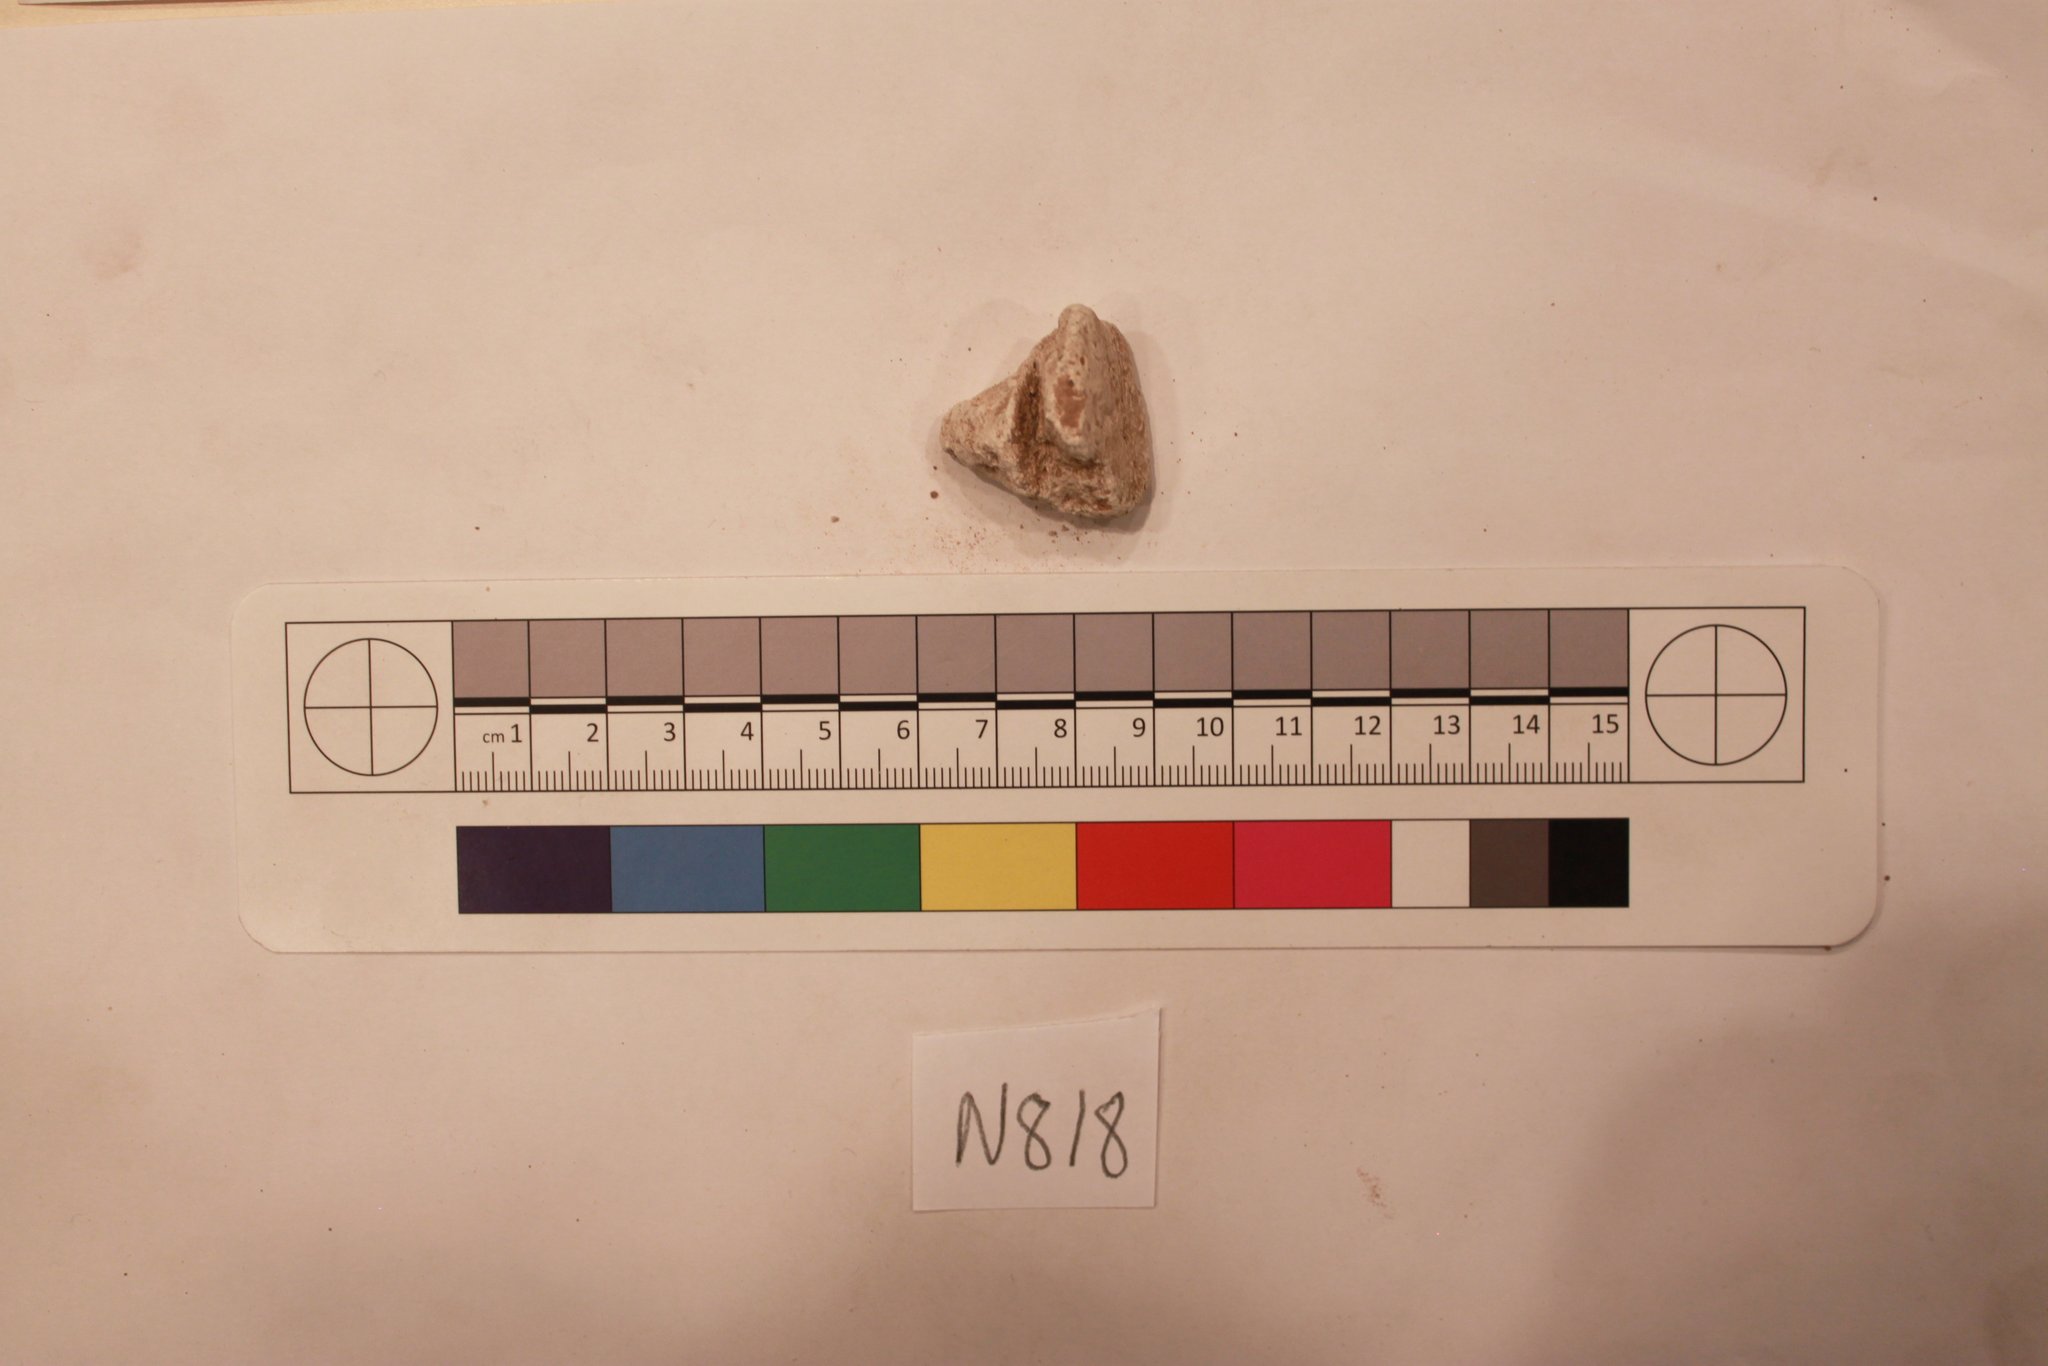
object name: fragment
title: Stucco Fragment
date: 701-1200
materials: plaster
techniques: carving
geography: iran